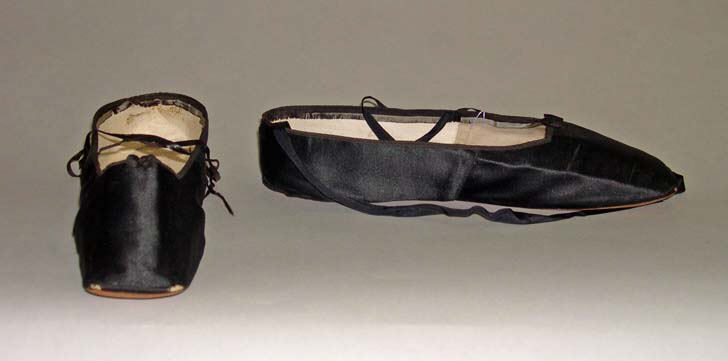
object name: slipper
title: Slippers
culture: european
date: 1830-1849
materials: silk